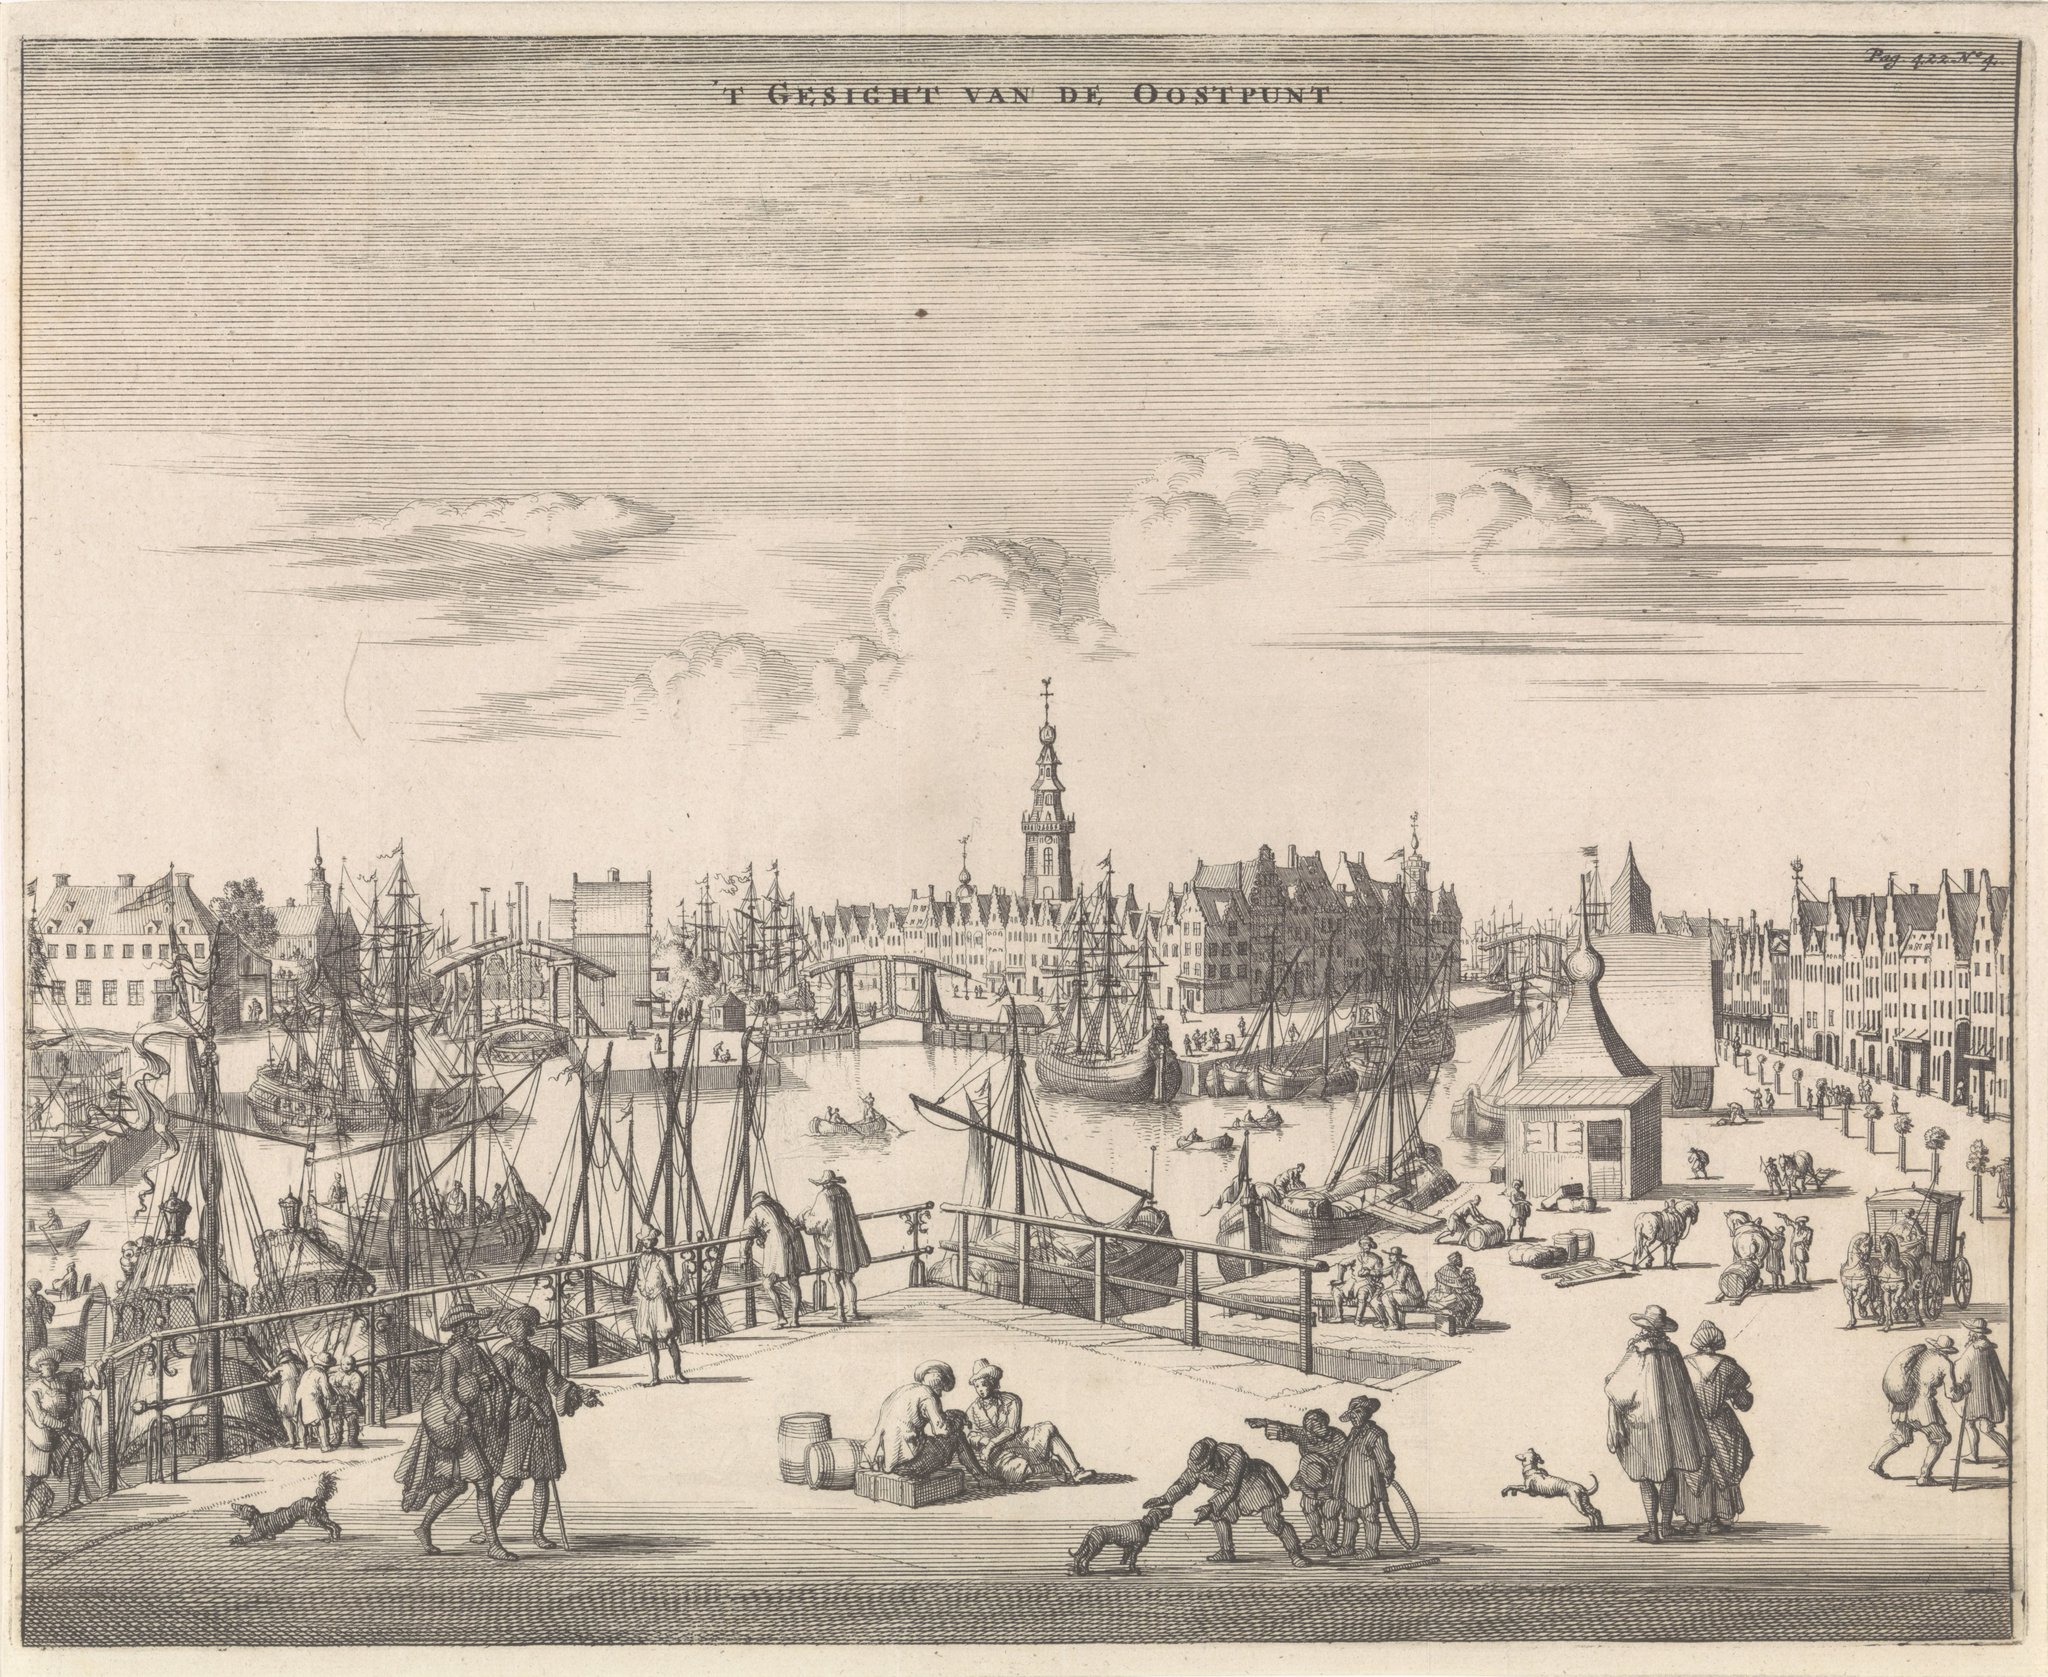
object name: print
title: Gezicht op de haven van en de stad Middelburg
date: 1696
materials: paper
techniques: engraving, etching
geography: amsterdam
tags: harbour, prospect of city, town panorama, silhouette of city, quay, middelburg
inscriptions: collector's mark: Lugt 2228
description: Huidige staat van prent ook gebruikt in: Smallegange, Mattheus. Nieuwe Cronyk van Zeeland (…). Middelburg en Amsterdam: Johannes Meertens en Abraham van Someren, 1696. Latere staat van prent (zonder nummering rechtsboven) ook gebruikt in: Aa, Pieter van der. La galerie agreable du monde (...). 66 delen. Leiden: Pieter van der Aa, 1728, dl. 20.